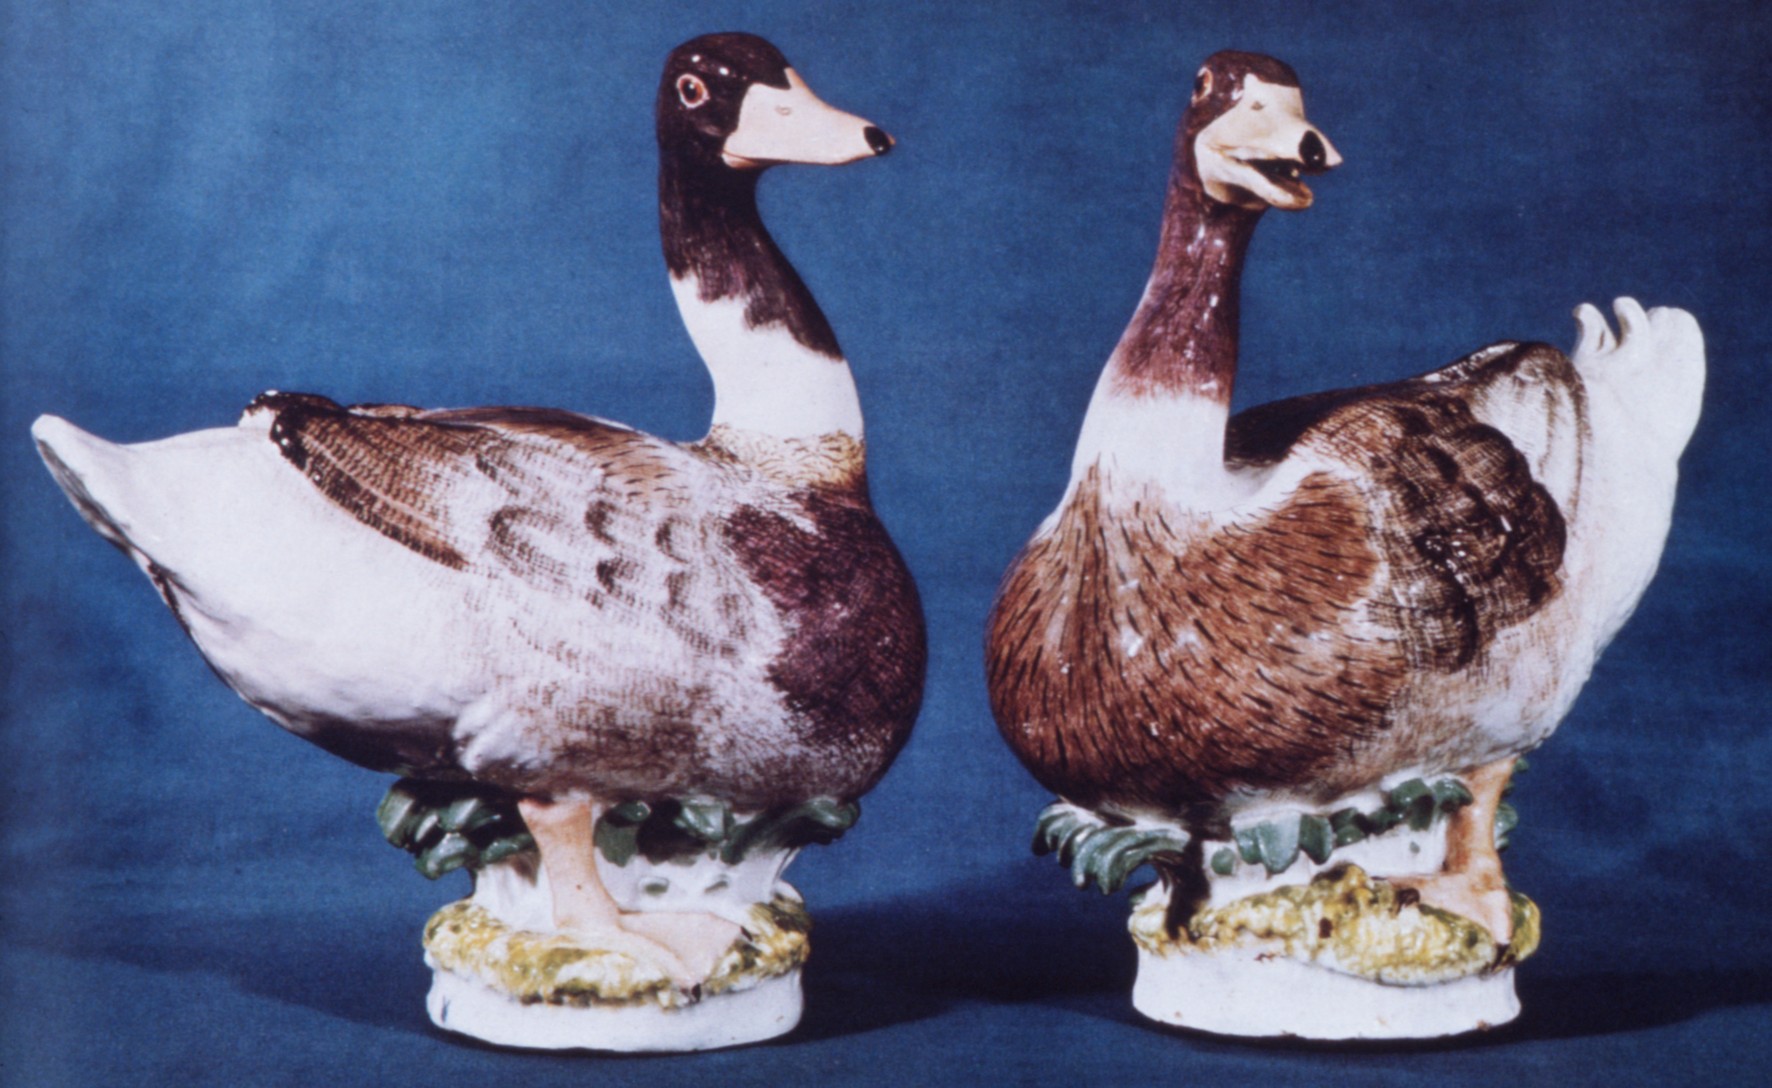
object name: figure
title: Mallard duck (one of a pair)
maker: meissen manufactory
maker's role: manufactory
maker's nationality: german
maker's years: 1710-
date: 1750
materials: hard paste porcelain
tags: ducks